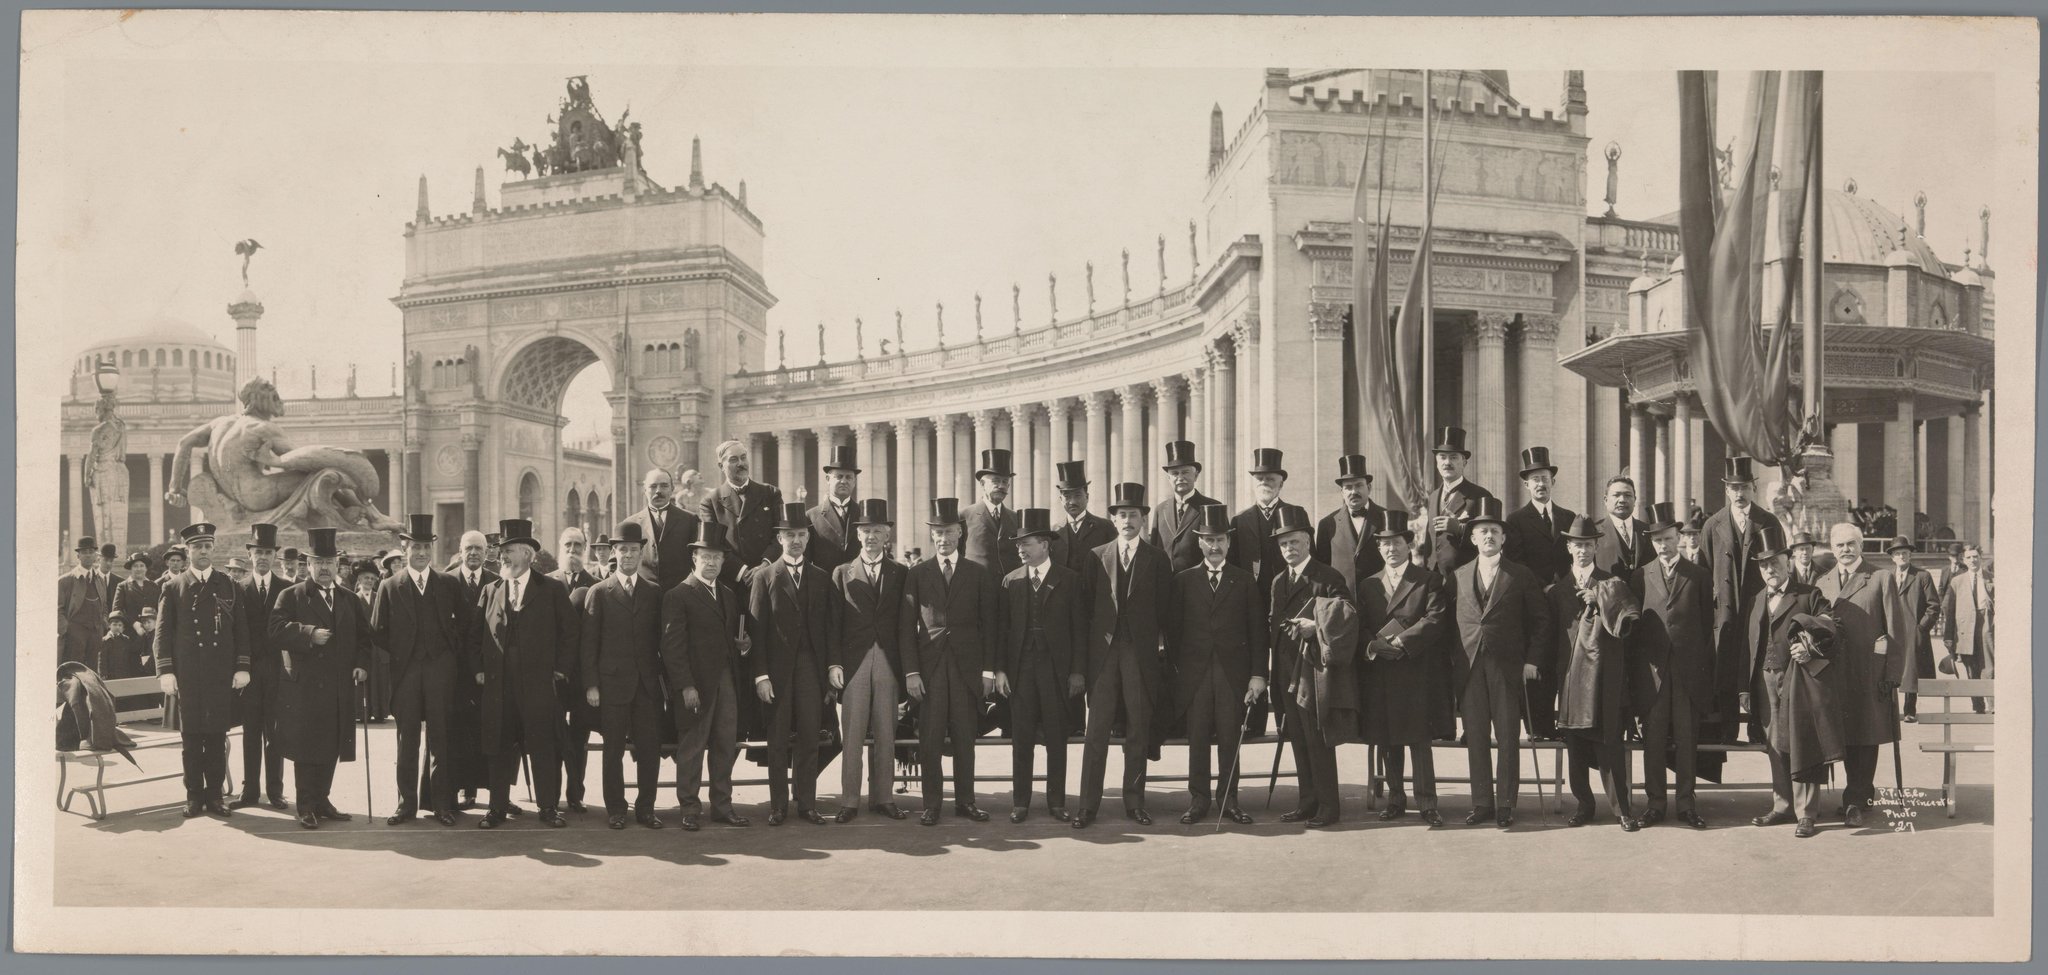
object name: photograph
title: Willem Witsen met groep in San Francisco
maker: Anonymous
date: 1860-1915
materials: paper, photographic support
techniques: gelatin silver print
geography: san francisco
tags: amsterdam, painter, print maker, draughtsman, willem witsen